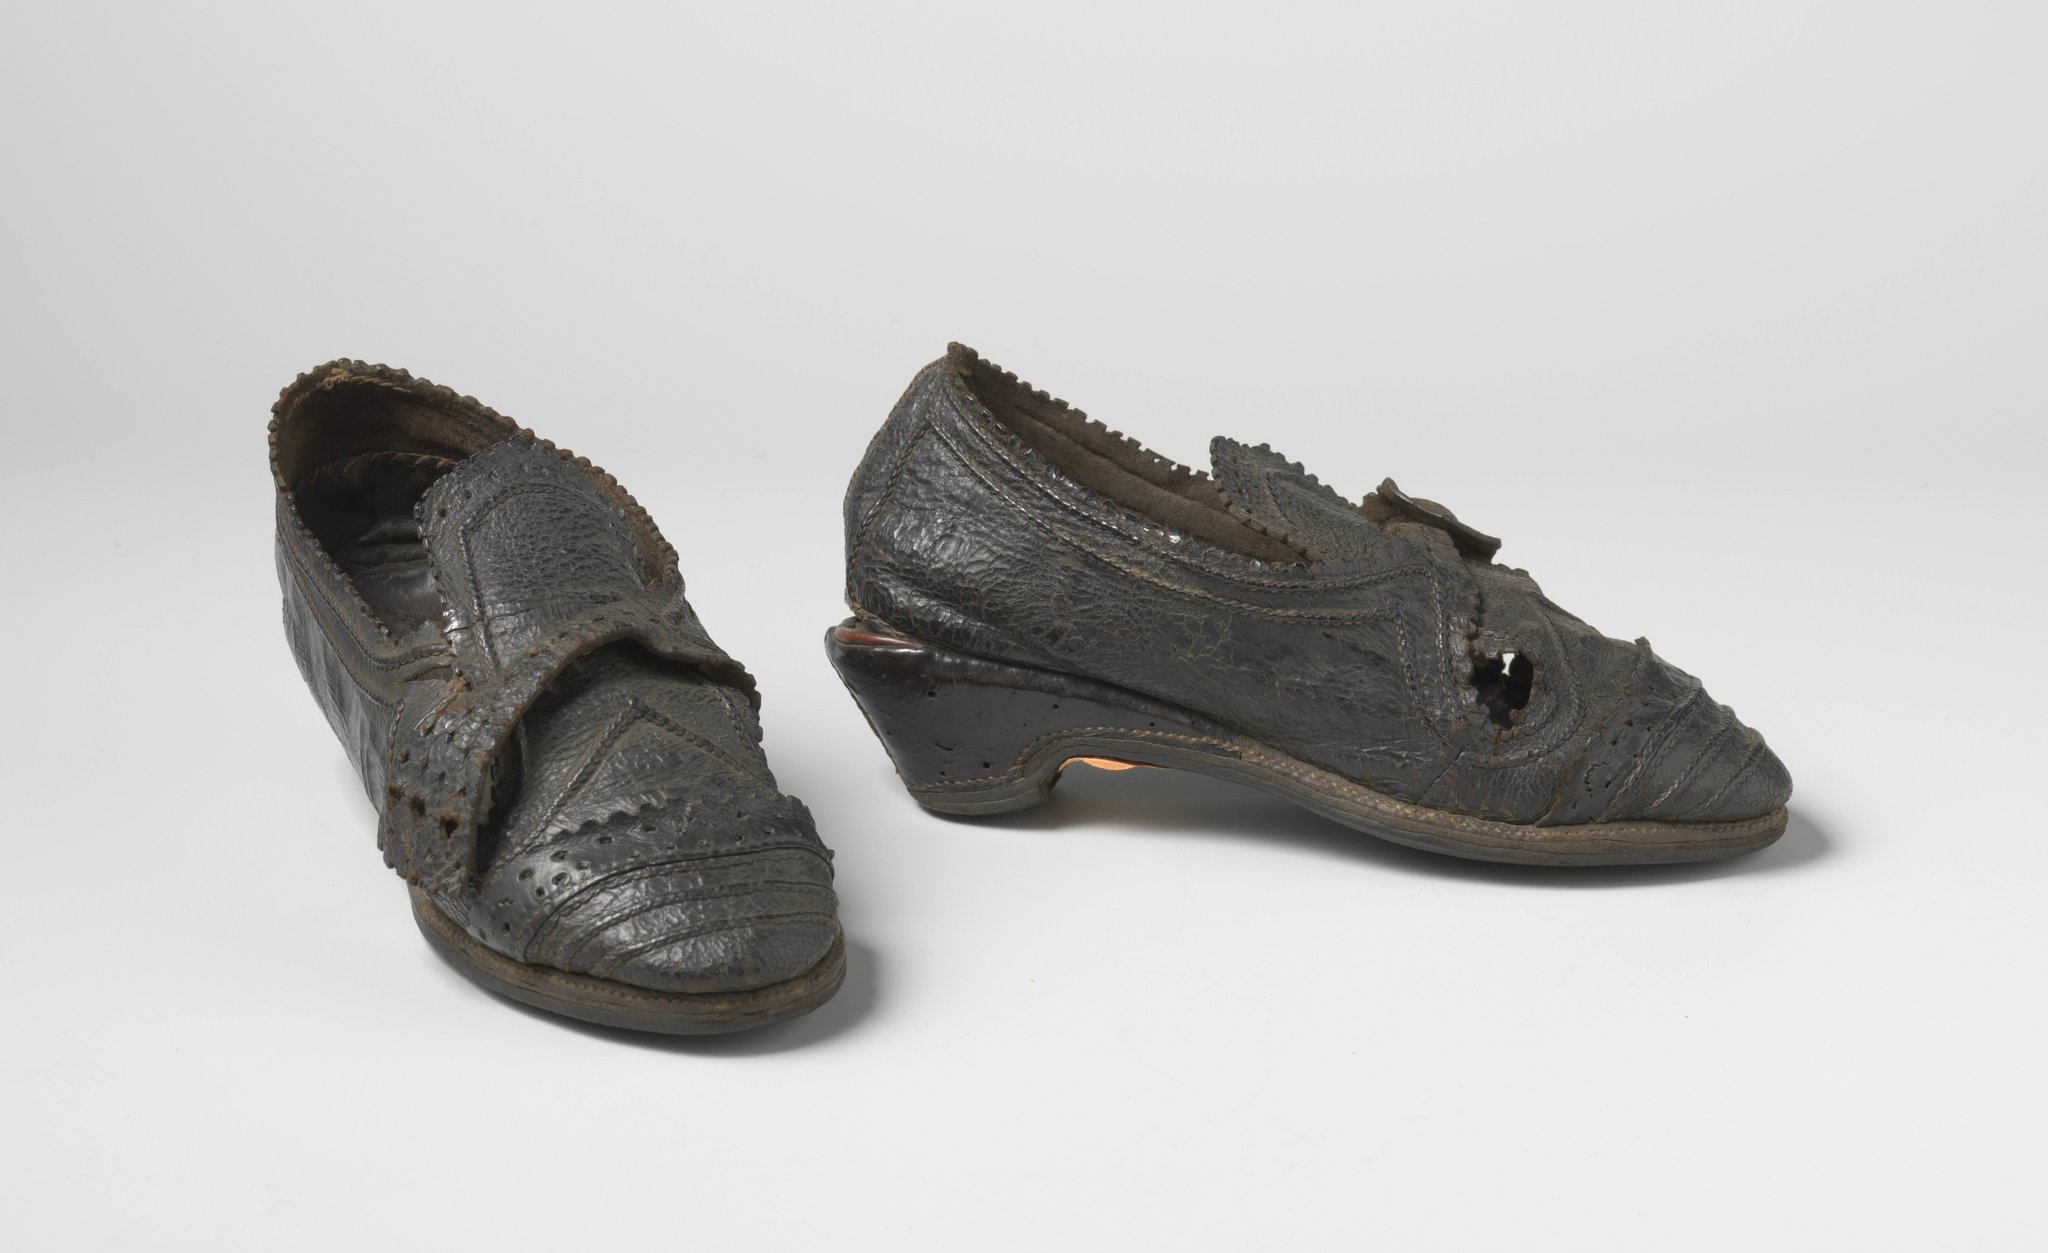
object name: womenswear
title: Damesschoen van runderleer met opstaande tong, versierd met perforaties en kartels, voorzien van lage hak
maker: Anonymous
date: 1600-1650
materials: leather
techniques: perforating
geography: northern netherlands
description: Schoen van zwart leer. Links-rechts symmetrisch. Het voorblad verloopt in een klep, waarover een riem gesloten wordt. De blokhak zit gedeeltelijk los, op welke plaats een bies van rood leer is aangebracht. Versiering van twee oprijgjes, perforaties en uittandingen. (verwant aan BK-NM-8430).